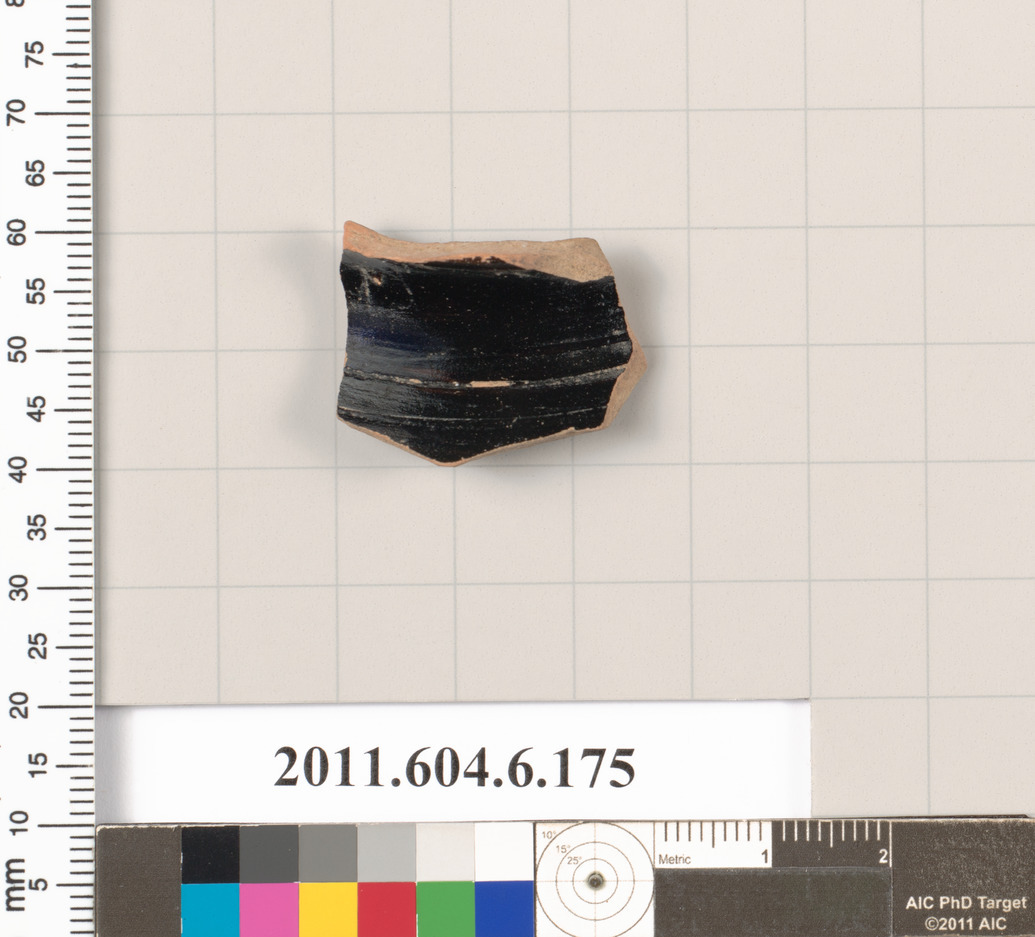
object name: oinochoe fragment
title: Terracotta fragment of an oinochoe (jug)?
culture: greek, attic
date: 500-401 BCE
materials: terracotta